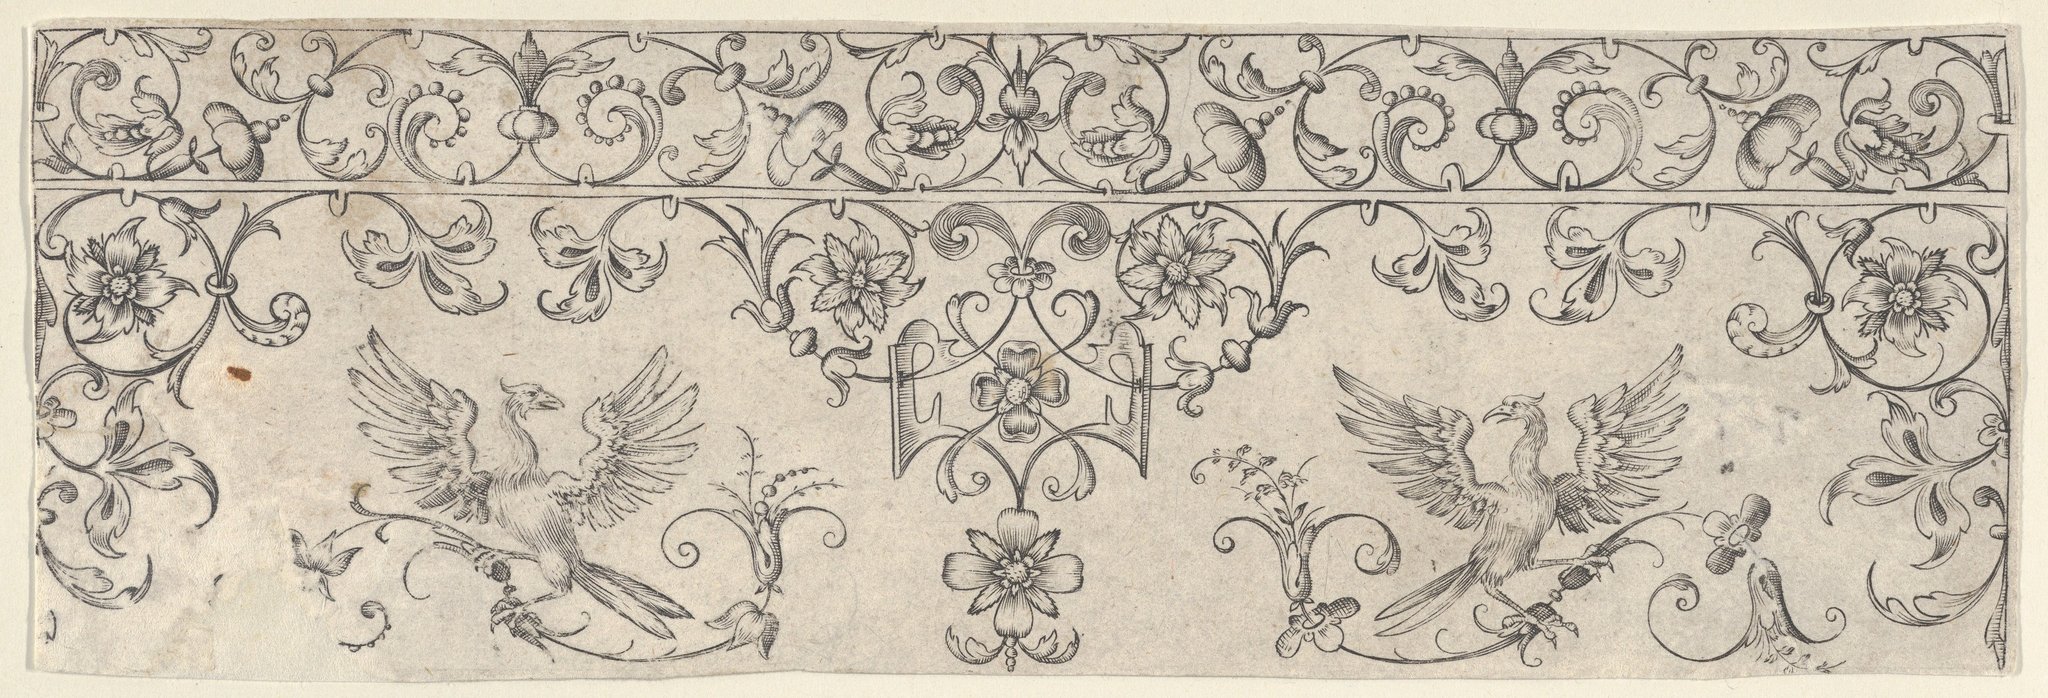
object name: ornament architecture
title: Plate 7, from "Friezes with Birds, Flowers and Meandering Wreaths and Scrolls"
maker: theodor bang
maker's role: artist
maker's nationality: german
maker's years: 1606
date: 1600-1617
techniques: etching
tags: birds,flowers